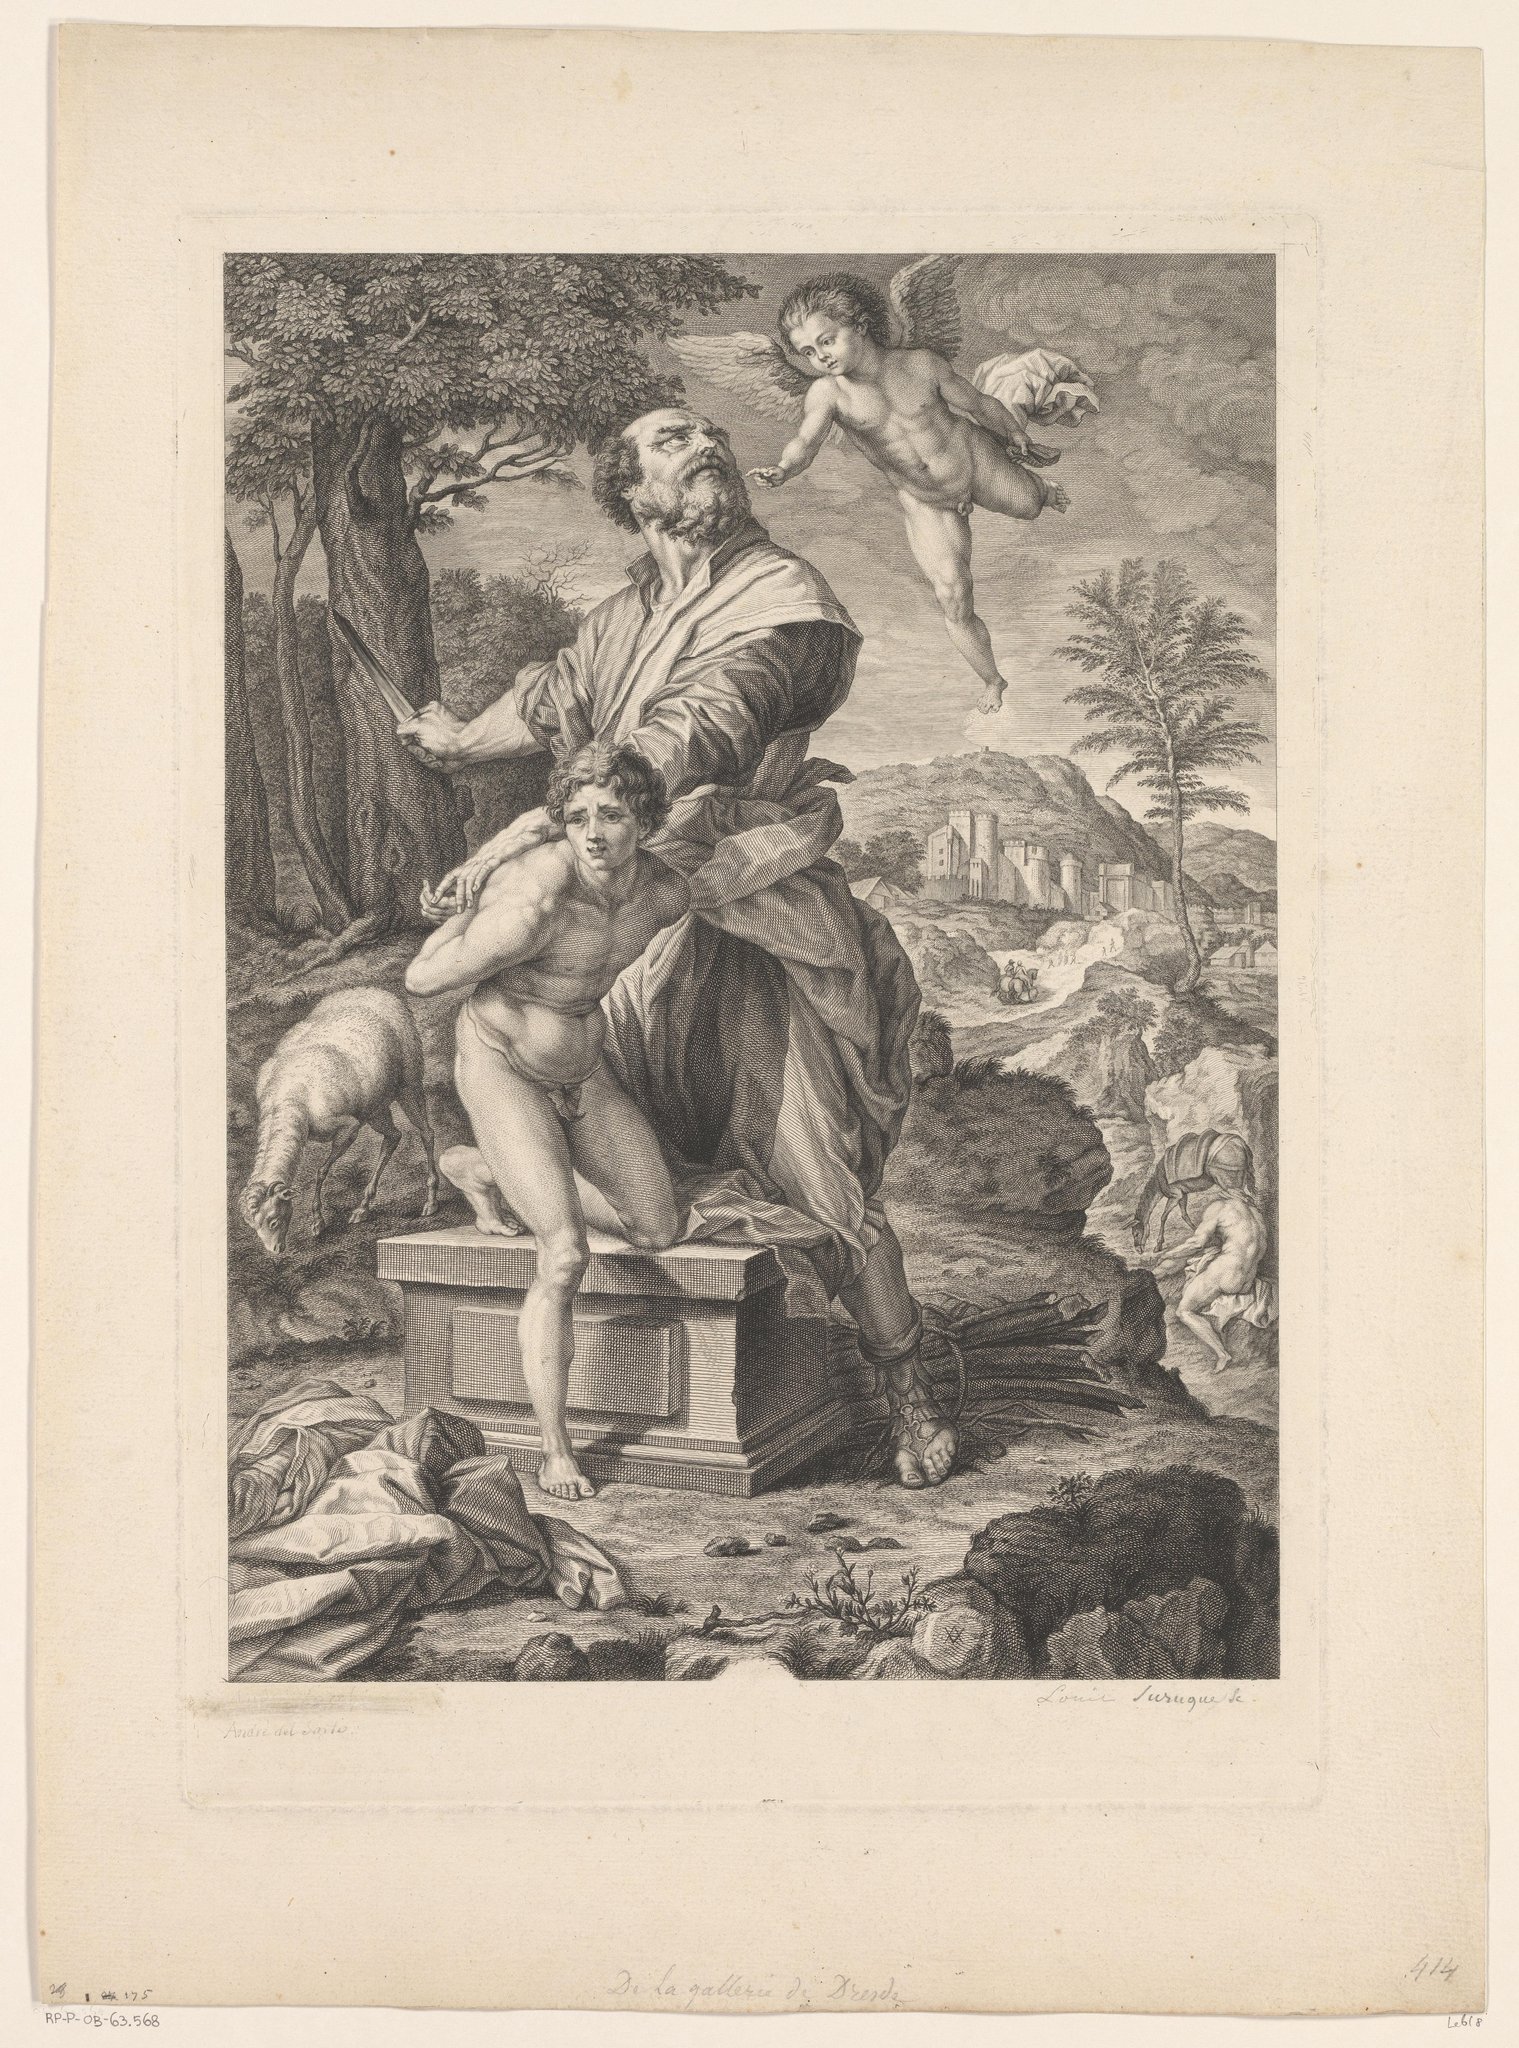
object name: print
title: Offer van Abraham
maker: louis surugue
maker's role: print maker, publisher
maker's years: 1686-1762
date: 1757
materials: paper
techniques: engraving, etching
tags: when abraham has his hand raised to kill isaac, an angel restrains abraham's hand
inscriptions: collector's mark: Lugt 240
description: Prent afkomstig uit de 'Recueil d'estampes d'après les plus célèbres tableaux de la Galerie Royale de Dresde', verschenen in twee delen in 1753 en 1757, met in totaal 100 prenten naar schilderijen in de koninklijke kunstcollecties te Dresden.